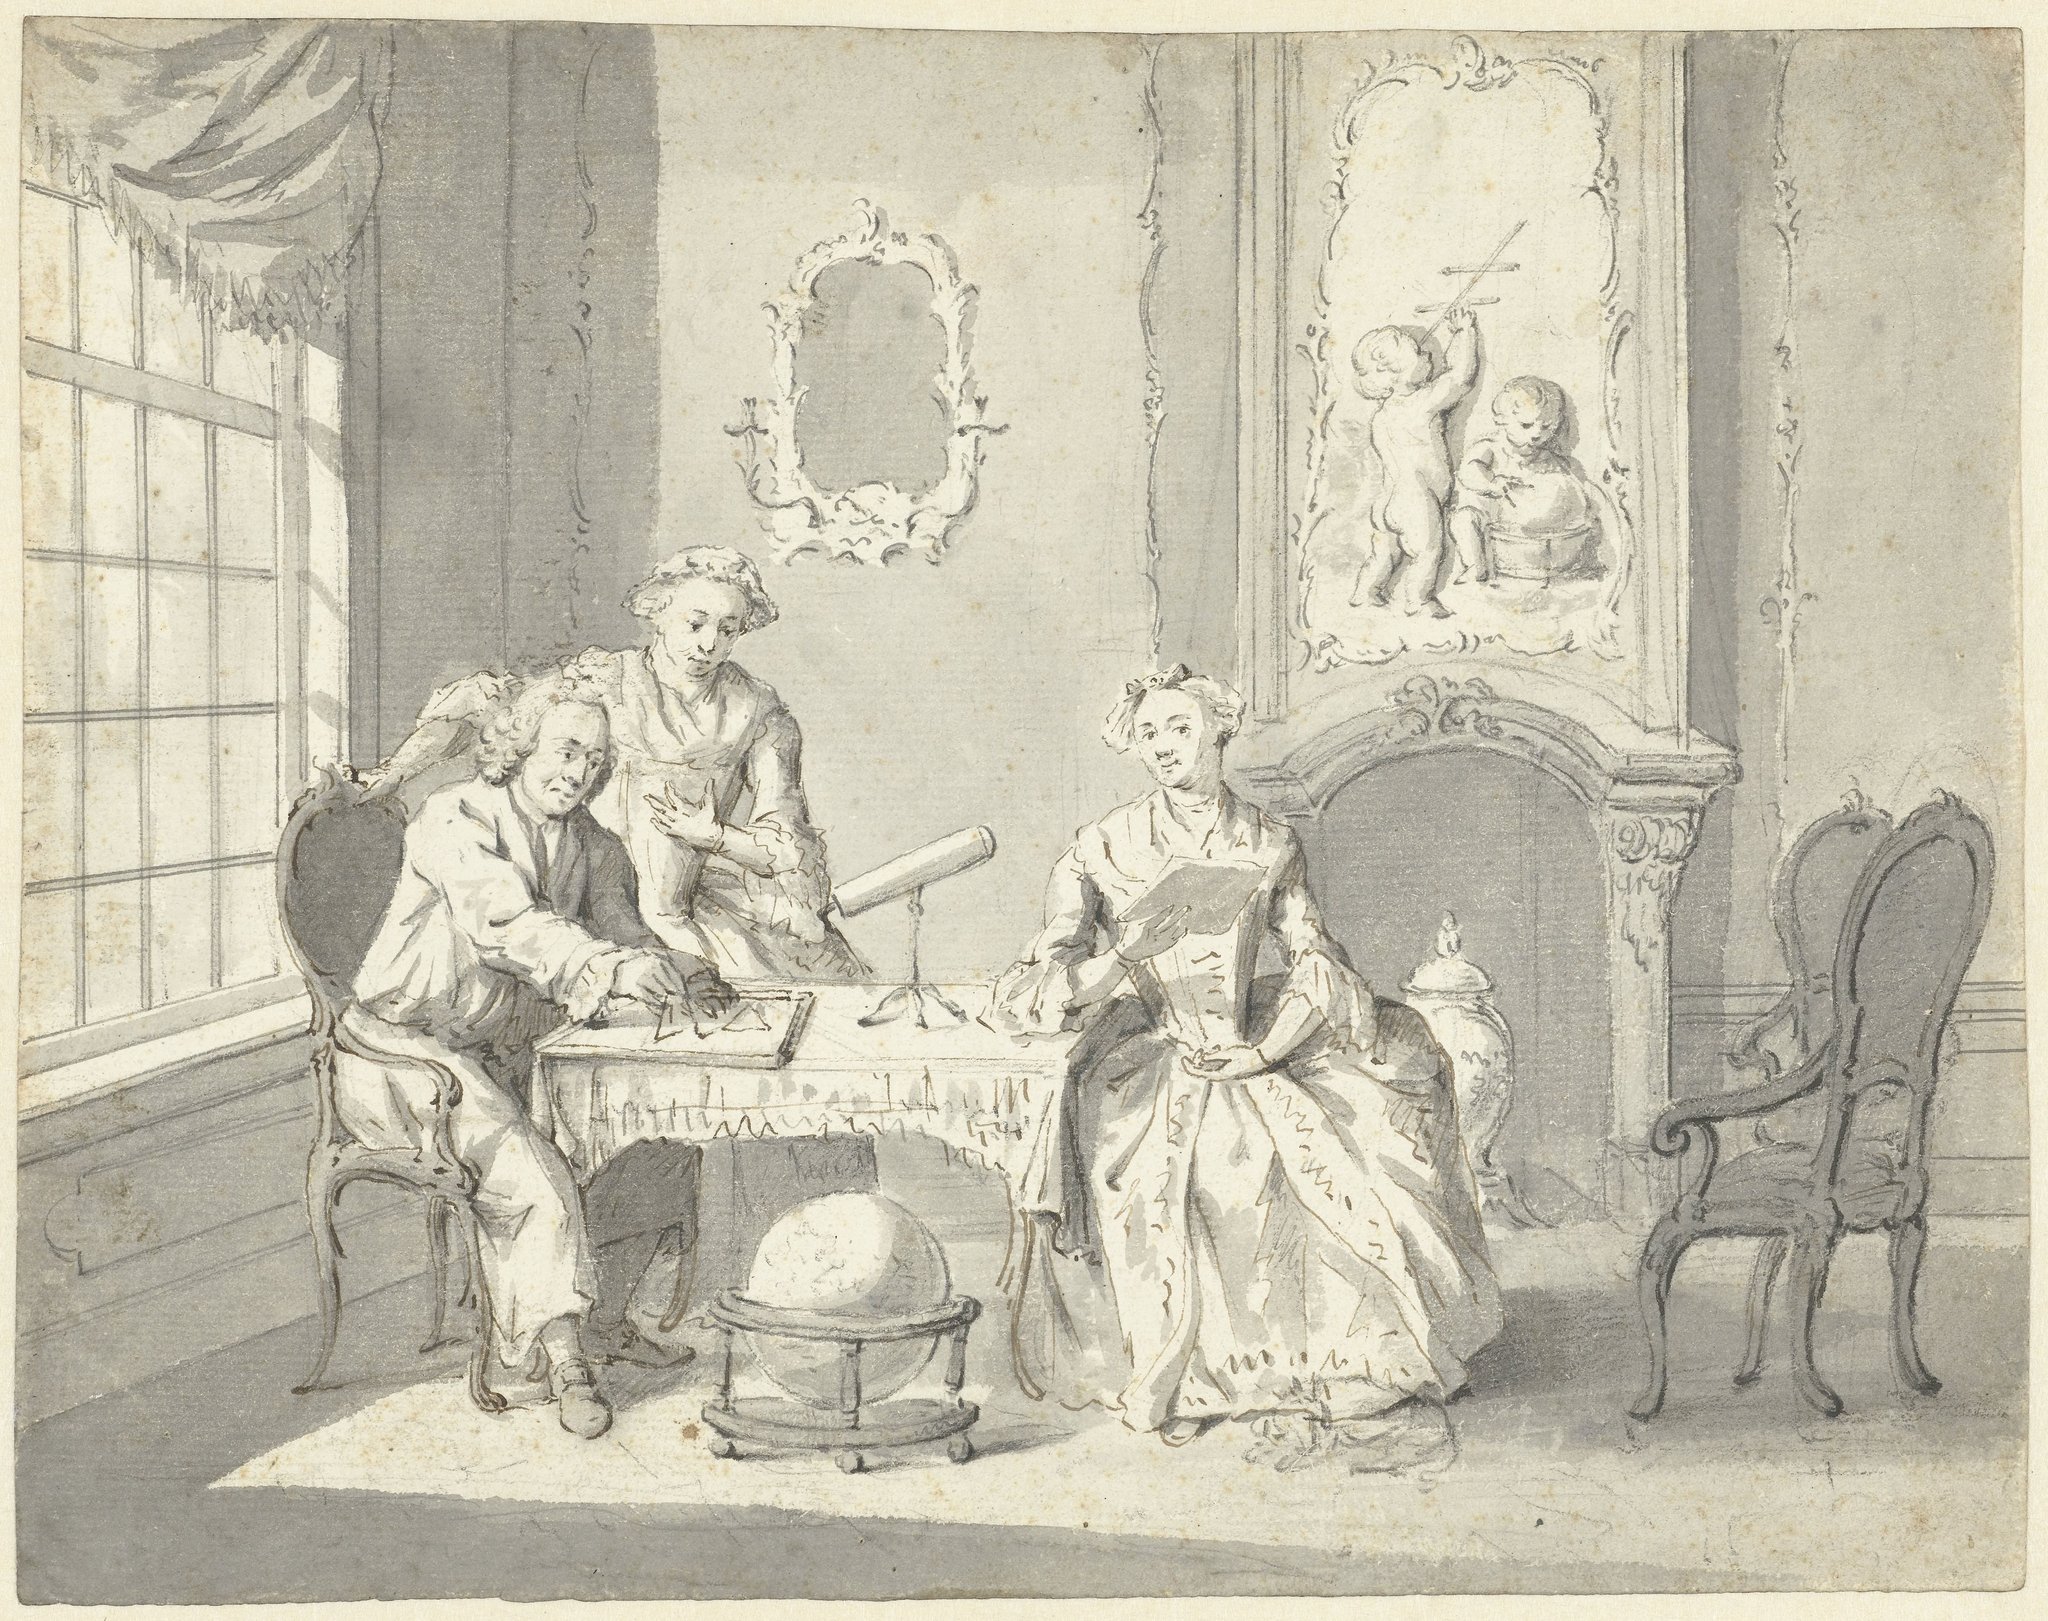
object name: drawing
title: Bij een sterrenkundige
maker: gerrit zegelaar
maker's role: draughtsman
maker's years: 1719-1994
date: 1729-1794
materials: chalk, ink, paper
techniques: brush, pen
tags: astronomy (and cosmography) (+ portrait of scholar, scientist), communal rooms